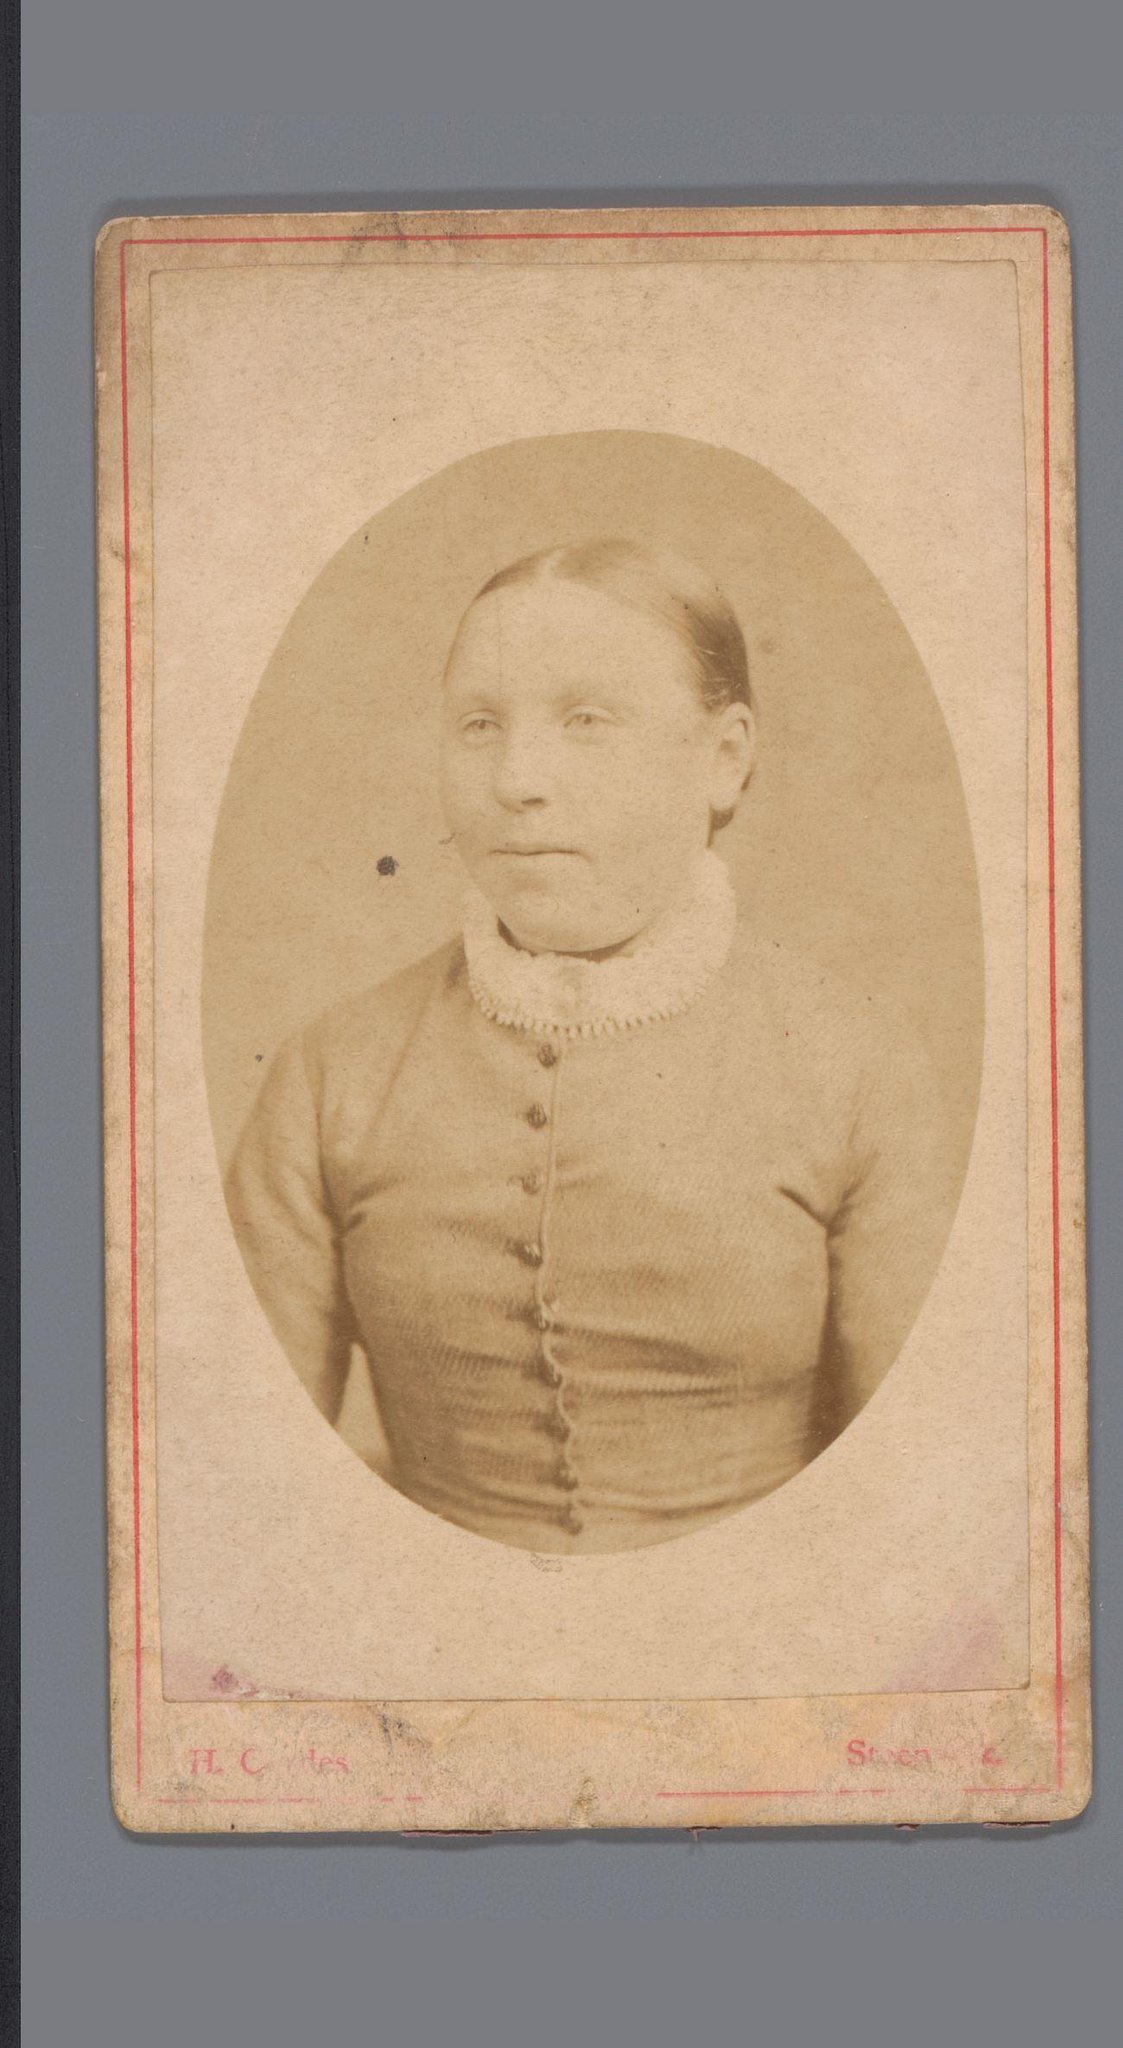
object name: photograph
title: Portret van een onbekende vrouw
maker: hendrik cordes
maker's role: fotograaf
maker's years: 1824-1902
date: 1865-1885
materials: cardboard, paper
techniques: albumen print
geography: steenwijk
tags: adult woman, anonymous historical person portrayed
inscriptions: address: ‘Oosterstraat No 36,/ Steenwijk.’, inscription: ‘Van alle portretten kunnen steeds nabesteld worden./ Byzondere inrichting voor vergrootingen à ch[arbon.]’